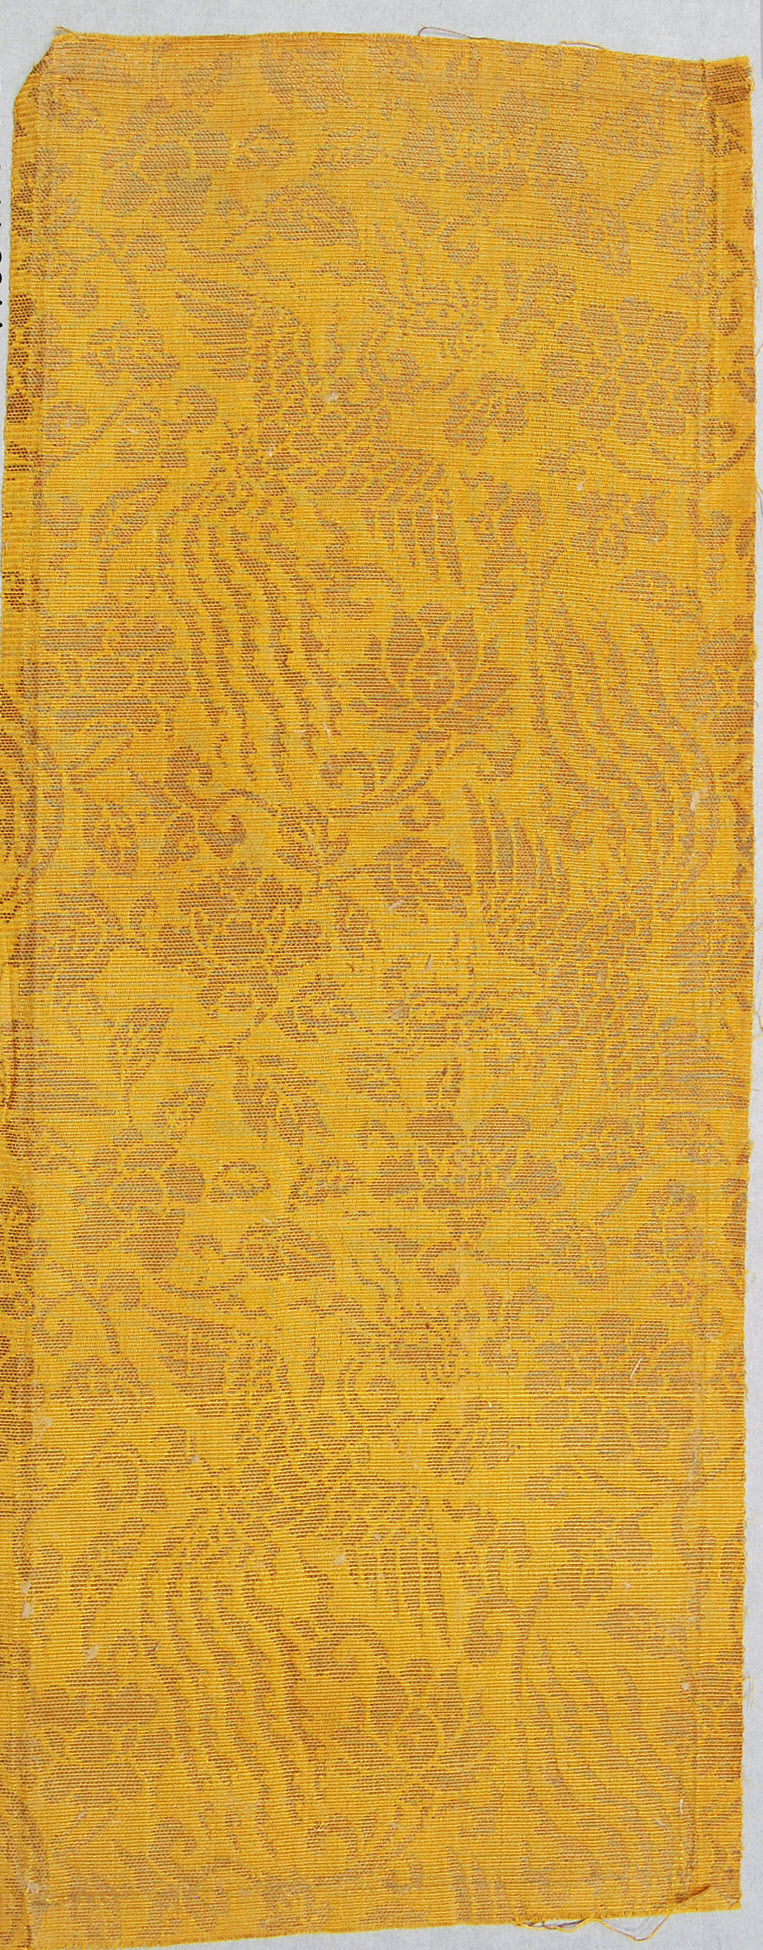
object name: sutra cover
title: Sutra Cover with Pattern of Phoenixes among Flowers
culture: chinese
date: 1501-1600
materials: metal thread, silk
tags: mythical creatures,flowers